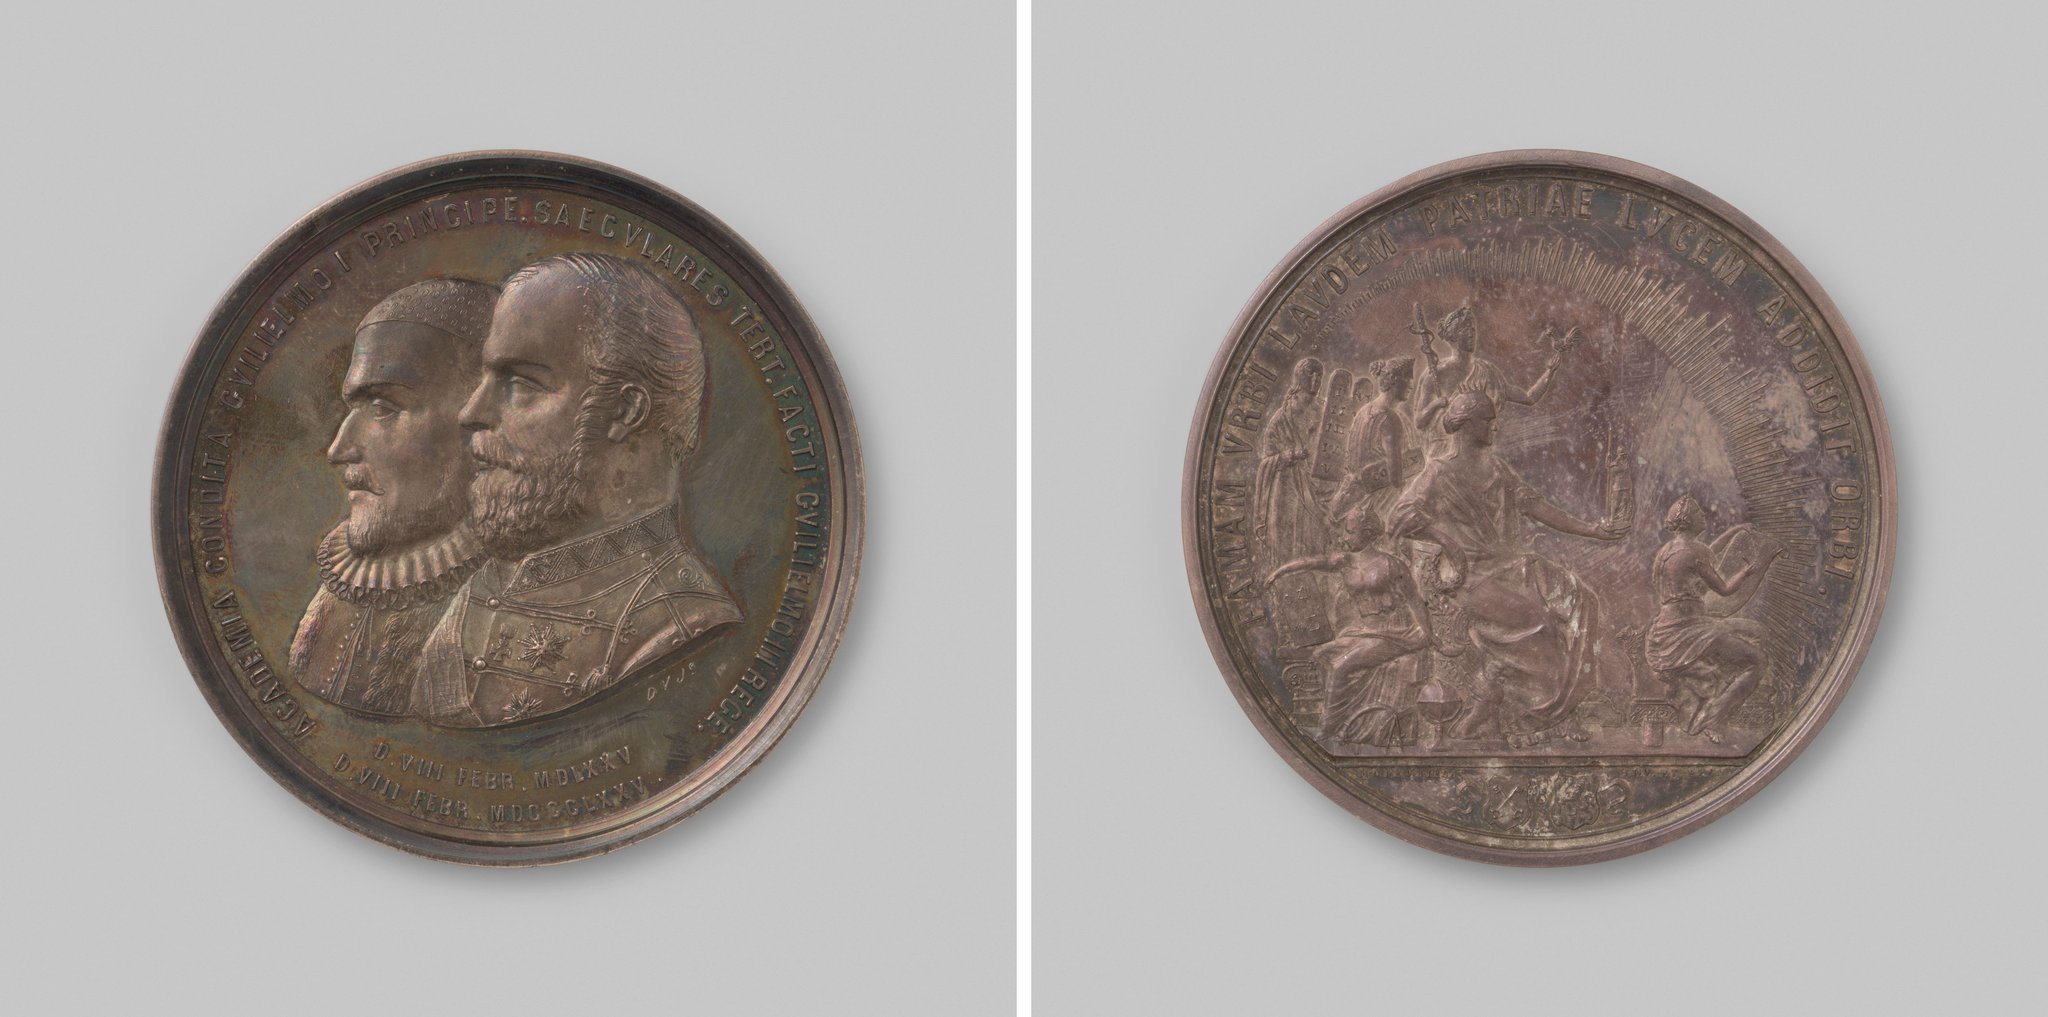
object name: history medal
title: Driehonderdjarig bestaan van de universiteit van Leiden, ter ere van Willem I, prins van Oranje-Nassau en Willem III, koning der Nederlanden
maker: moses cohen de vries junior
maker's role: diamantslijper, graveur, medailleur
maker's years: 1807-1883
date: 1875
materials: silver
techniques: striking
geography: amsterdam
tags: brussels, willem iii (koning der nederlanden), delft, william i (prince of orange), leiden